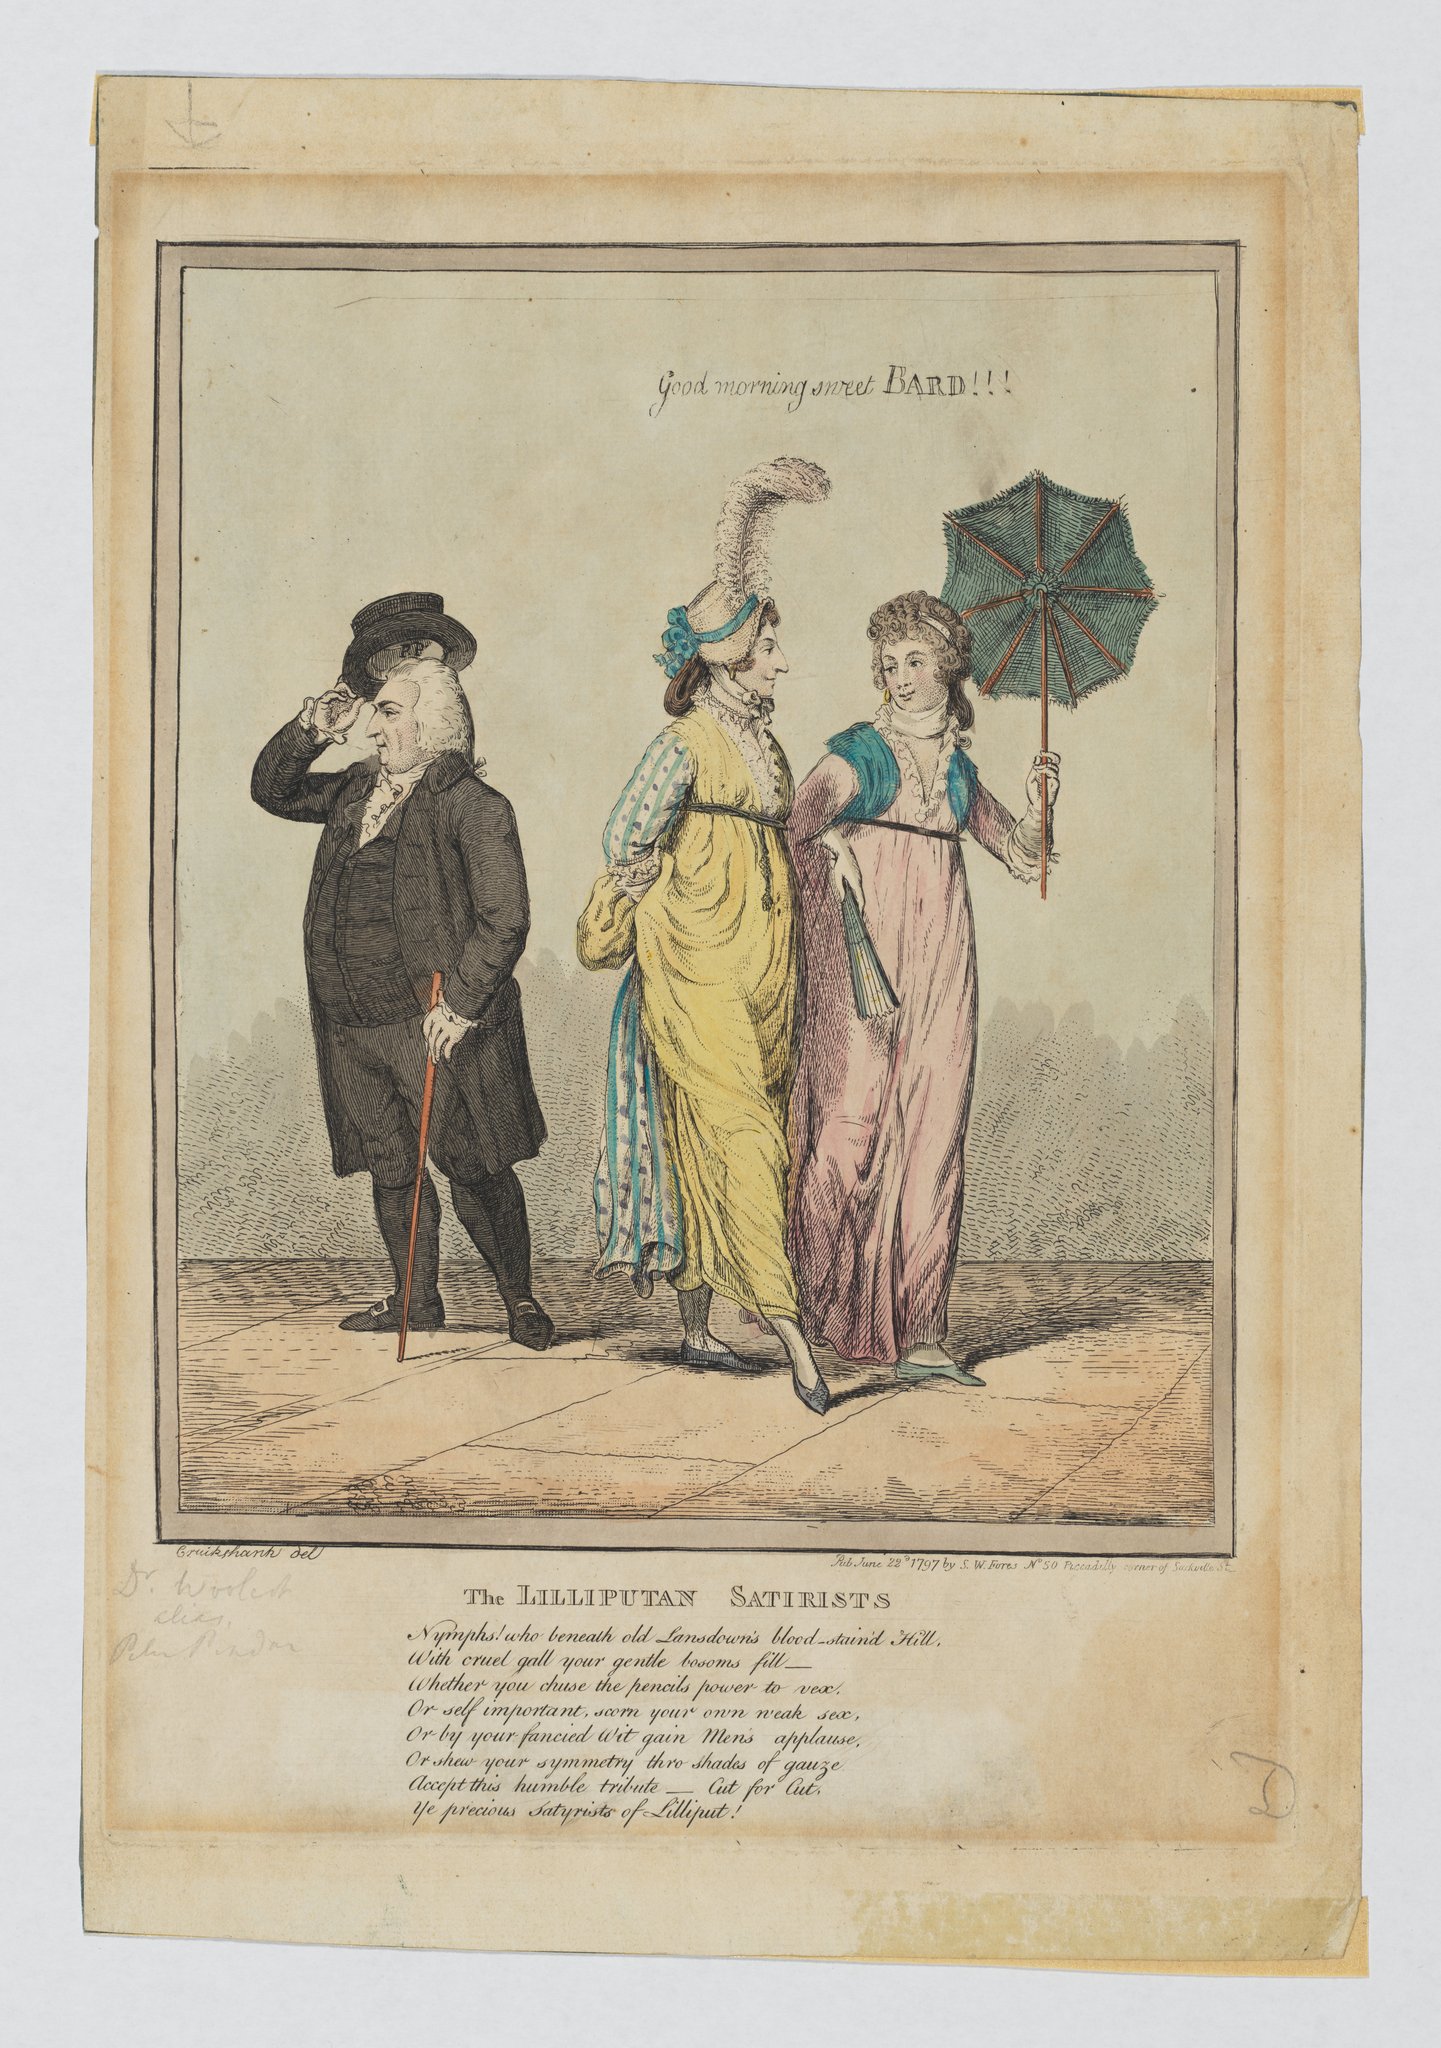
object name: print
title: The Lilliputan Satirists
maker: isaac cruikshank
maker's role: artist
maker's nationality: british, scottish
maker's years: 1764-1811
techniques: etching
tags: satire,men,women,parasols